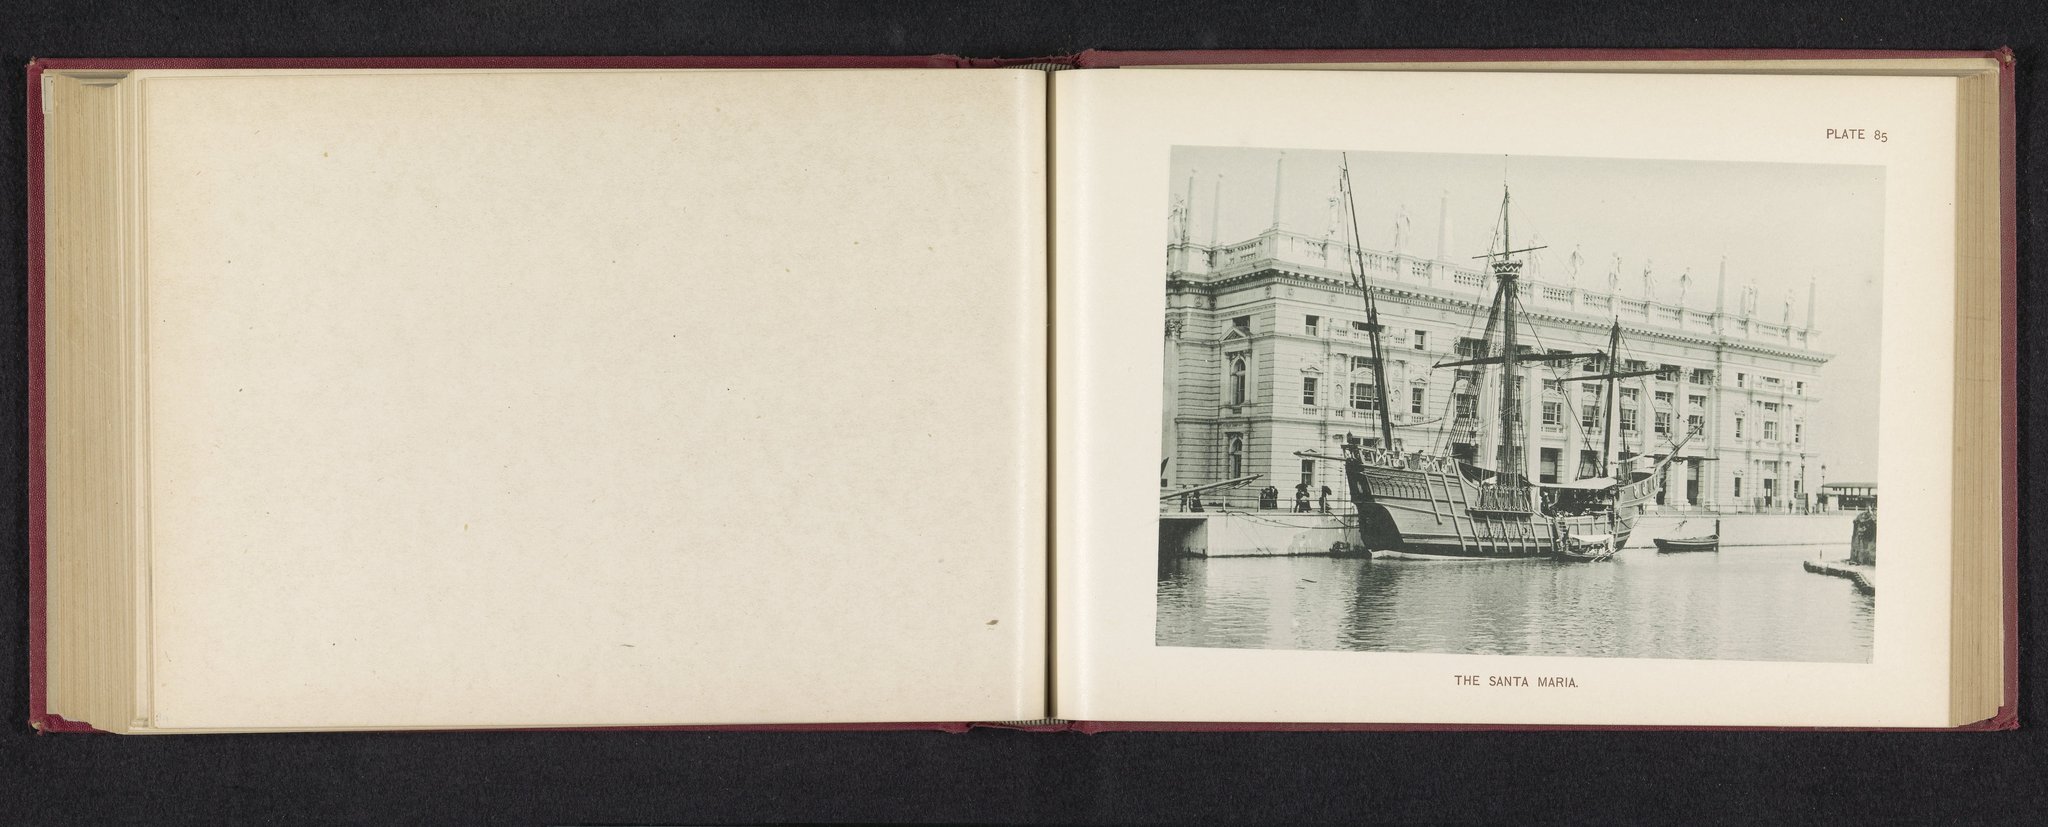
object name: page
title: The Santa Maria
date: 1893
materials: paper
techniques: photograph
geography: chicago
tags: world fair, world exhibition, ships (in general)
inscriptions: number: ‘Plate 85’